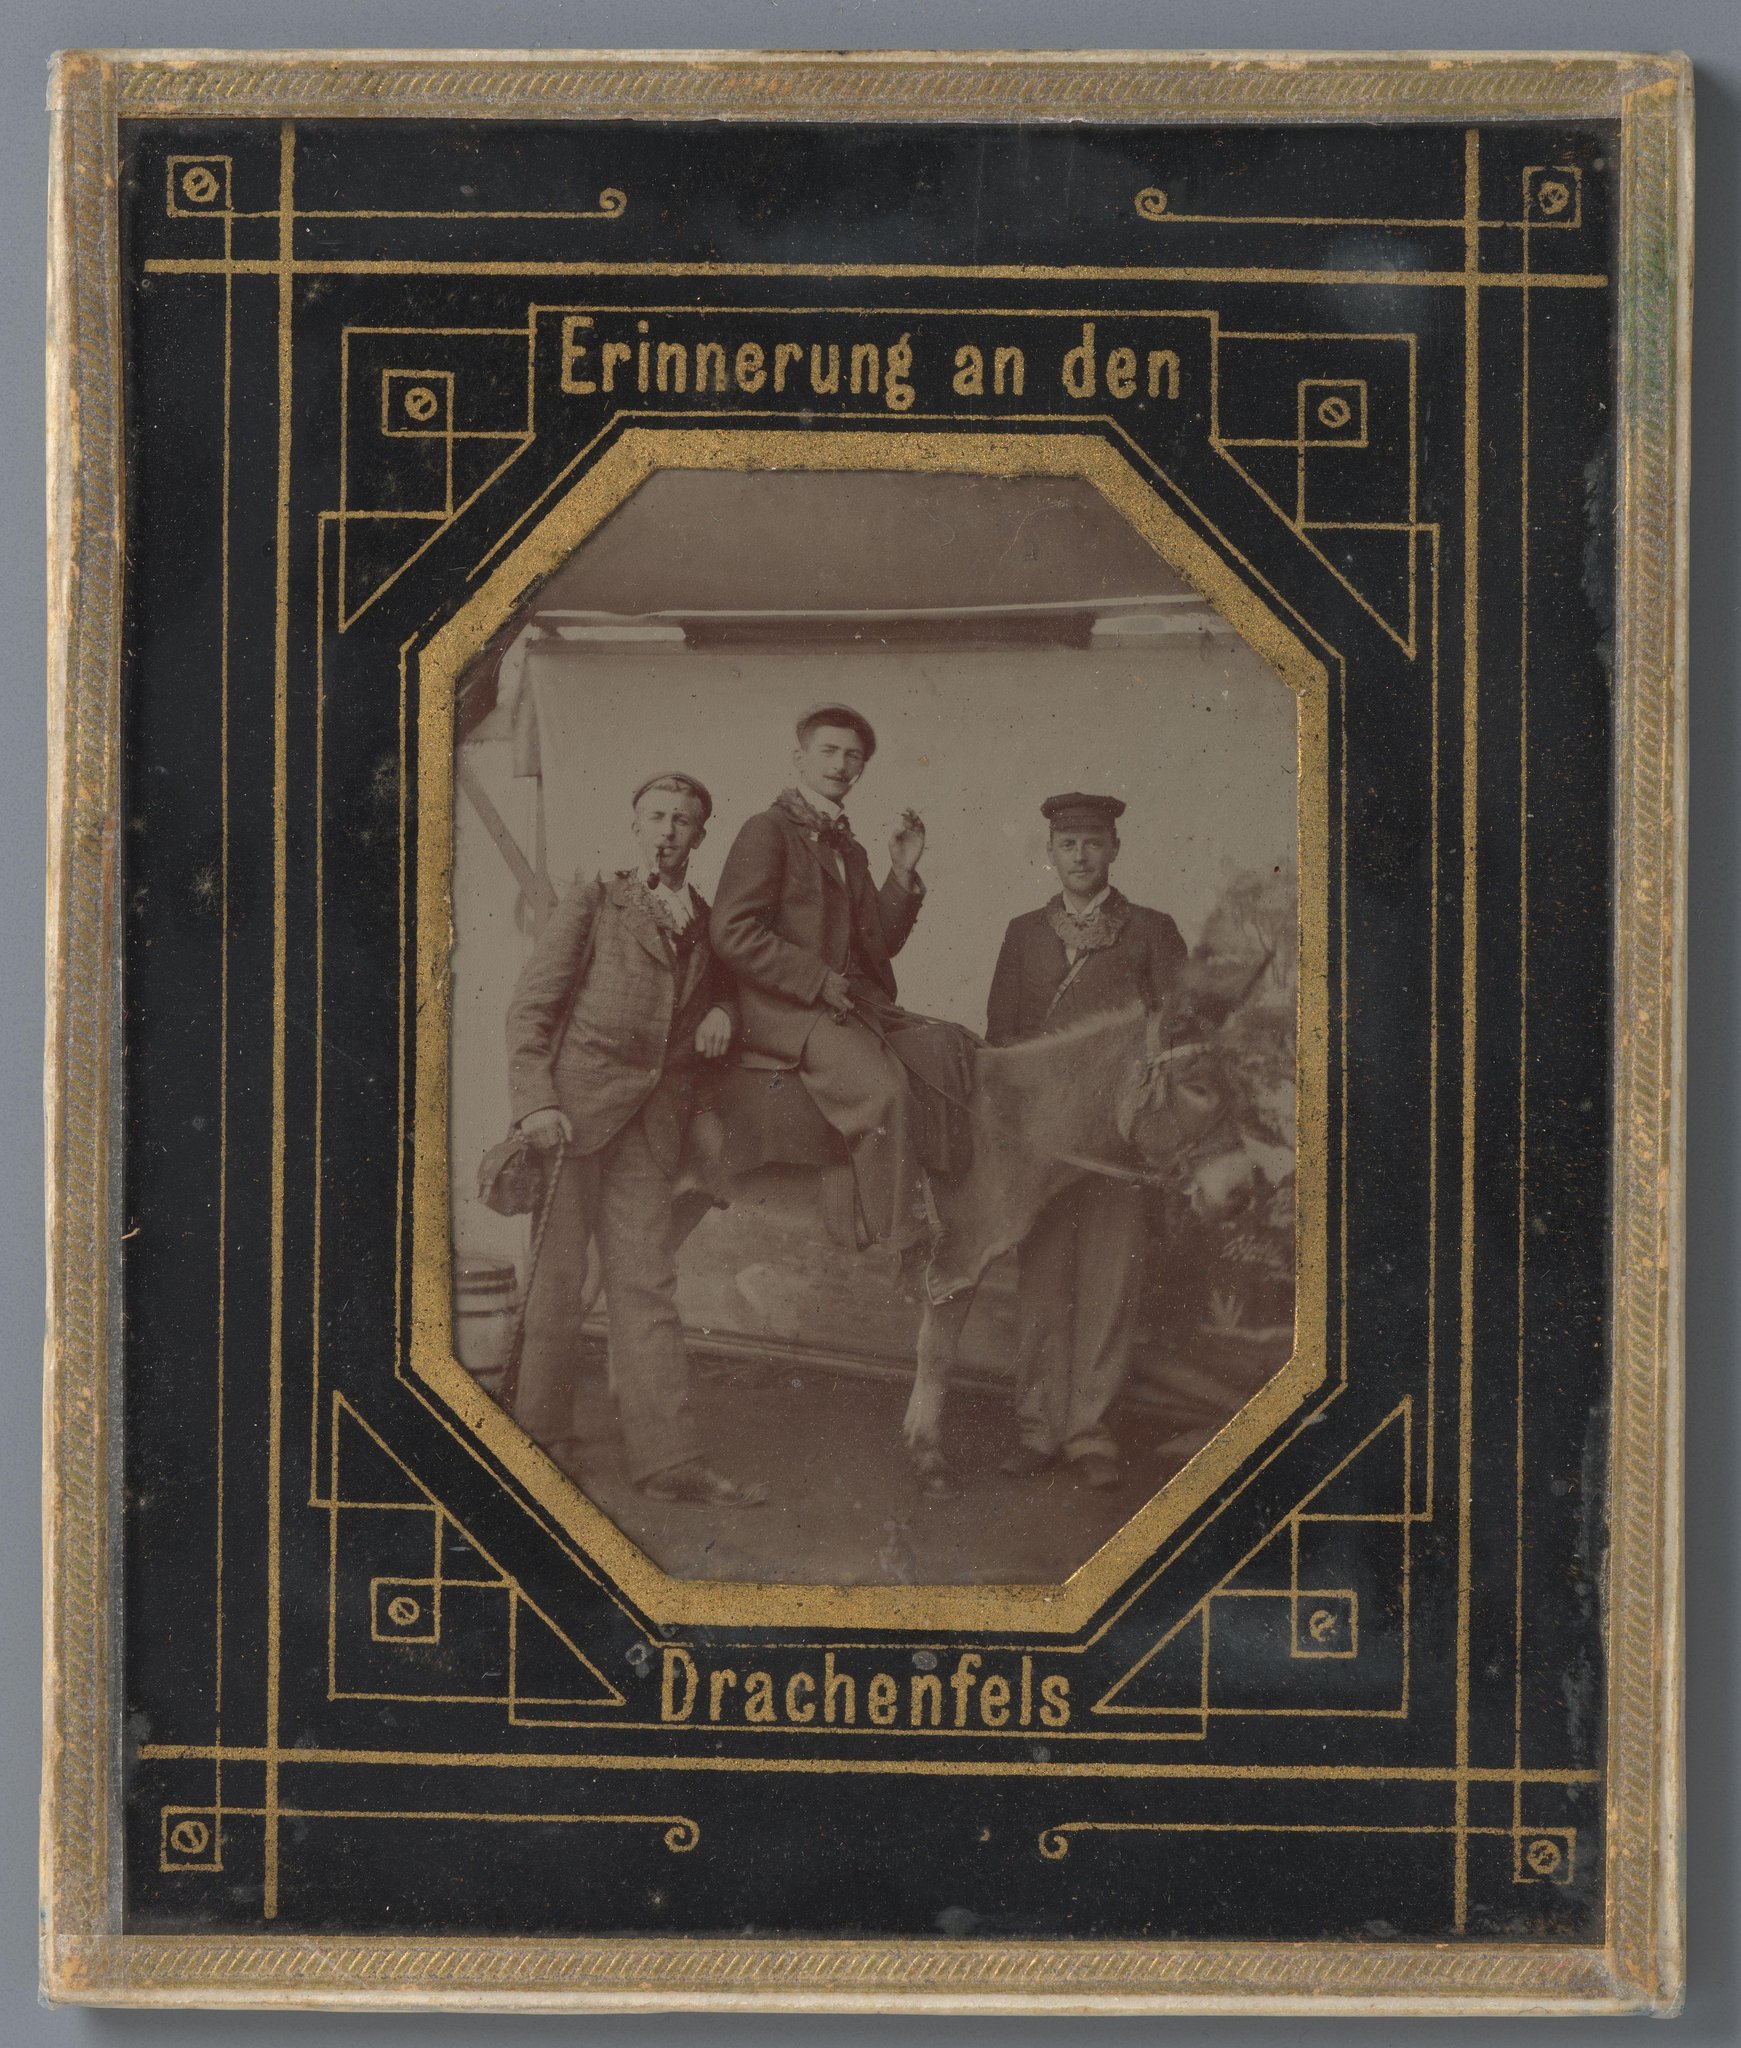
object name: frame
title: Portret van drie jongemannen, waarvan één zittend op een ezel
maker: wilhelm cronenberg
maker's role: fotograaf, schrijver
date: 1855-1900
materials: iron, paper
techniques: ferrotyping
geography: königswinter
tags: ass, donkey, historical persons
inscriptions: inscription: ‘Erinnerung an den Drachenfels’, inscription: ‘Photographiesches Atelier/ von/ We. Wilh. Cronenberg/ Königswinter a. Rh./ Drachenfels’